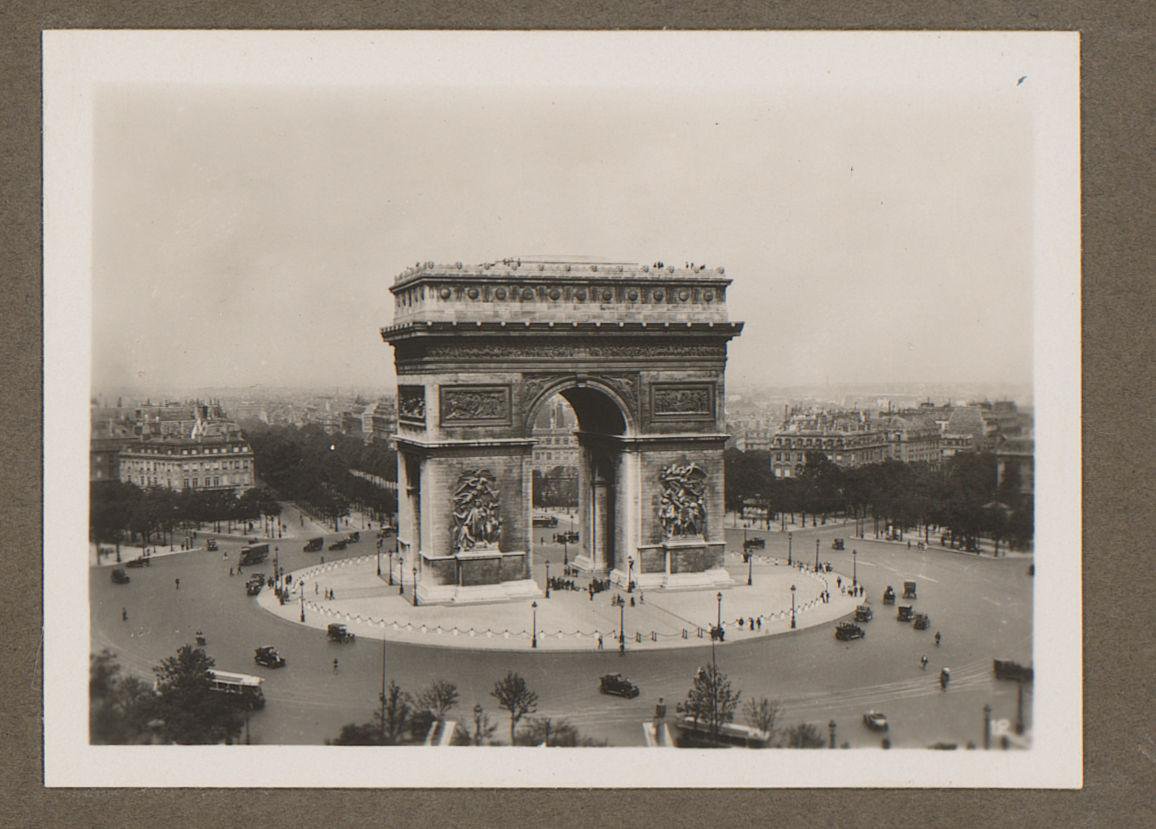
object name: album leaf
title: Gezicht op de Arc de Triomphe, Parijs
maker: Anonymous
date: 1928-1933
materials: paper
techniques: gelatin silver print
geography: paris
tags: triumphal arch